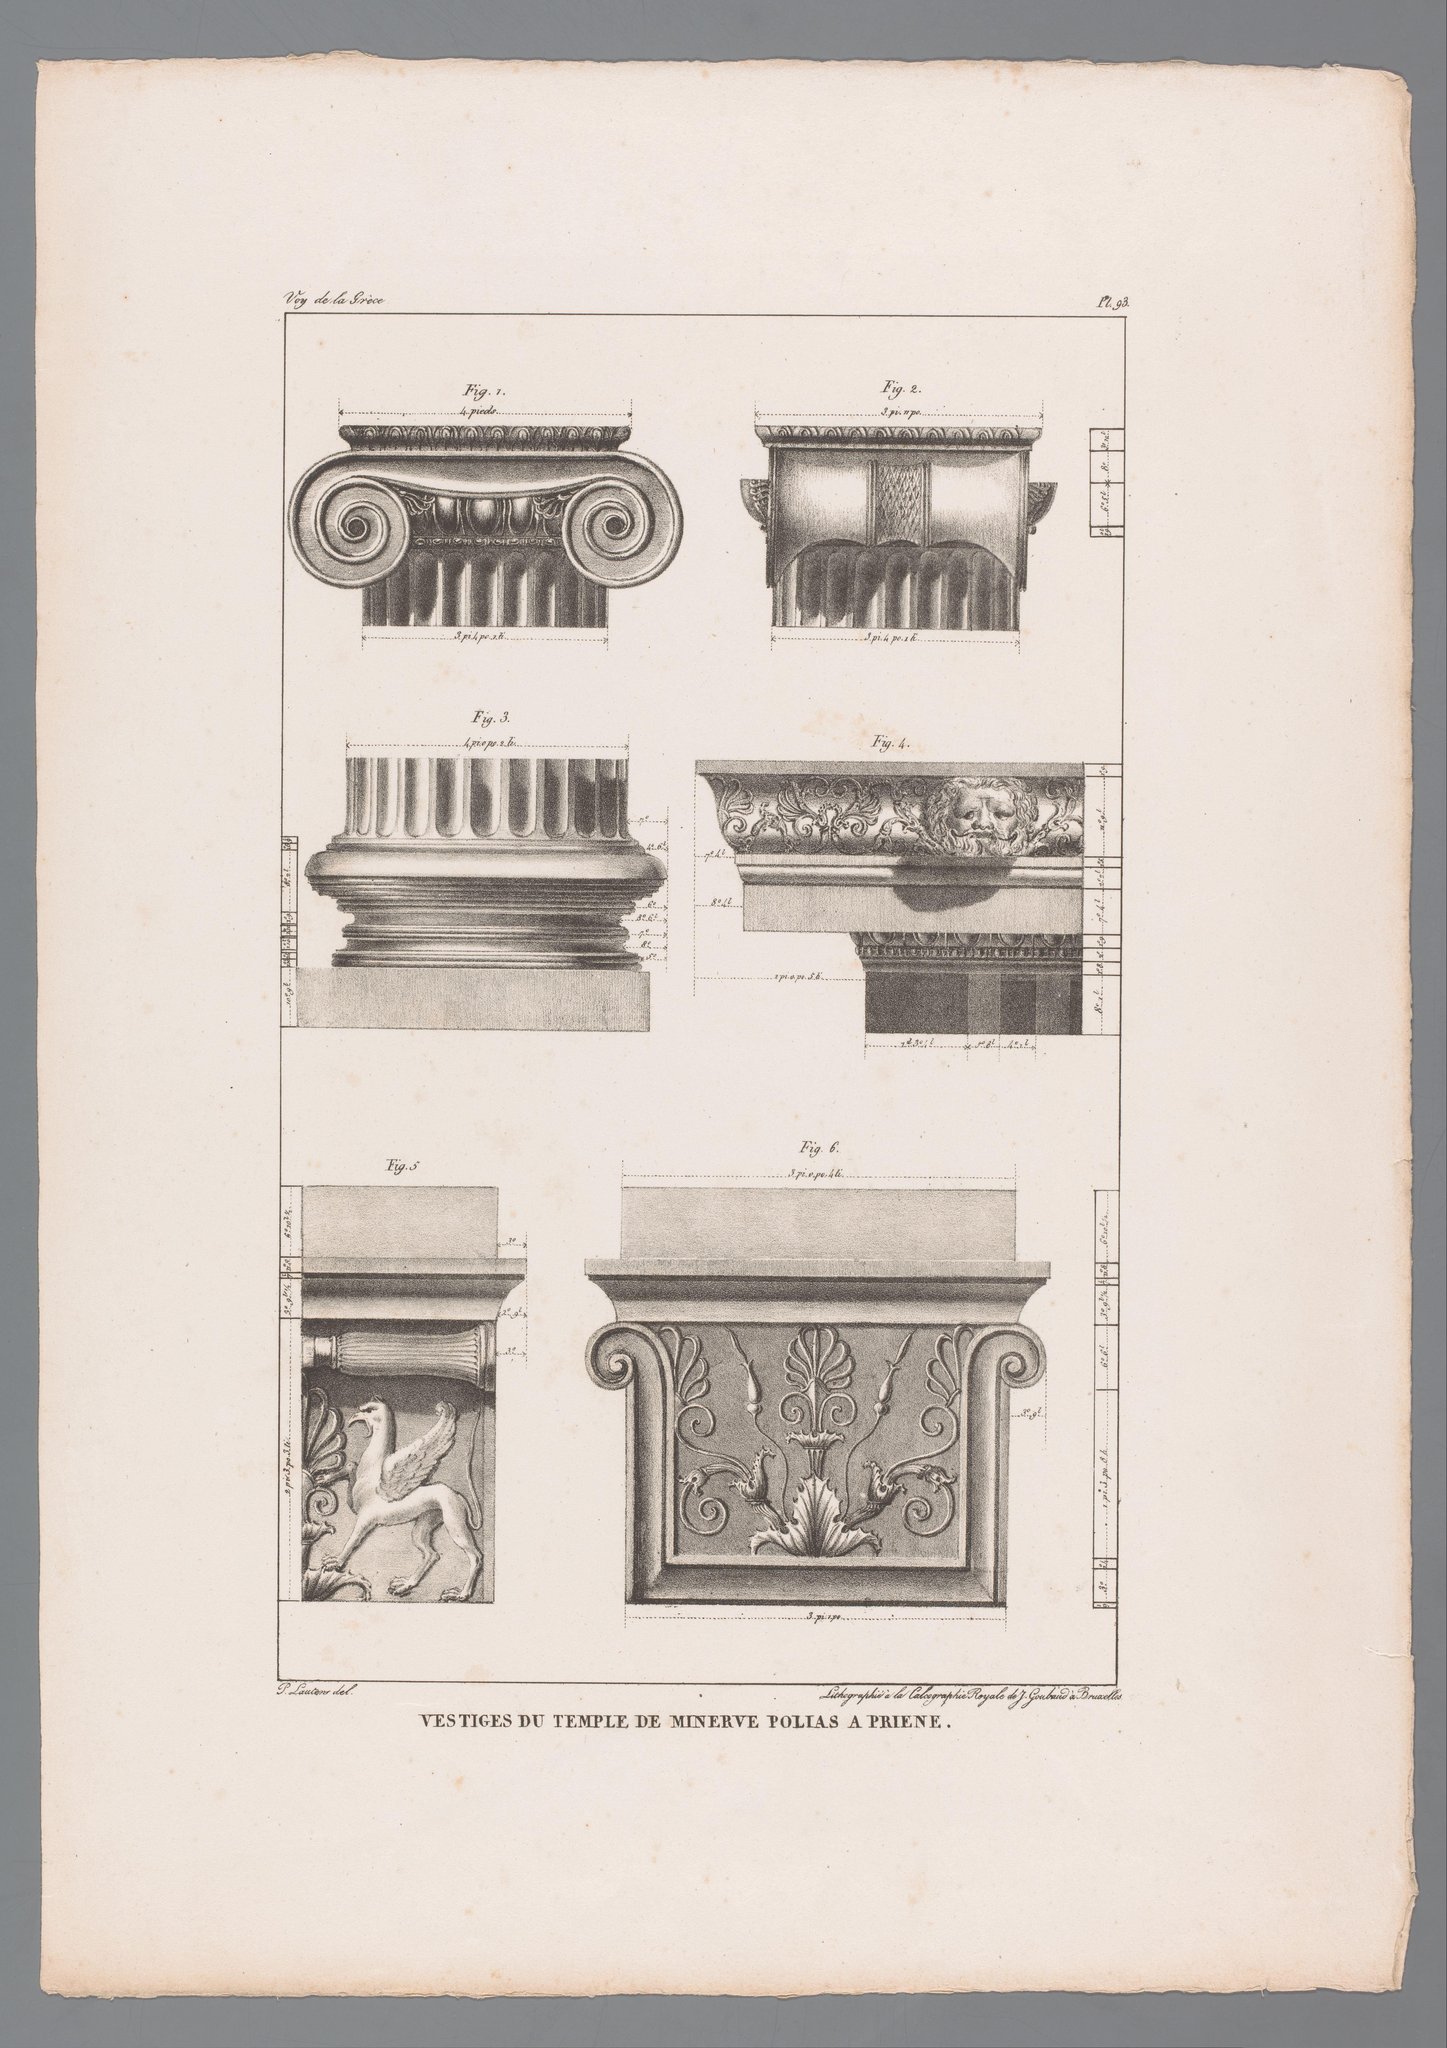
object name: print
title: Vestiges du temple de Minerve Polias a Priene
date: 1822-1825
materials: paper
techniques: lithograph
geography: brussels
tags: temple, shrine ~ greek religion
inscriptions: collector's mark: Lugt 2228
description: Prent waarschijnlijk verschenen in: Choiseul-Gouffier, Marie-Gabriel-Auguste-Florent. Voyage pittoresque de la Grèce. Parijs: s.n., 1822-1825.